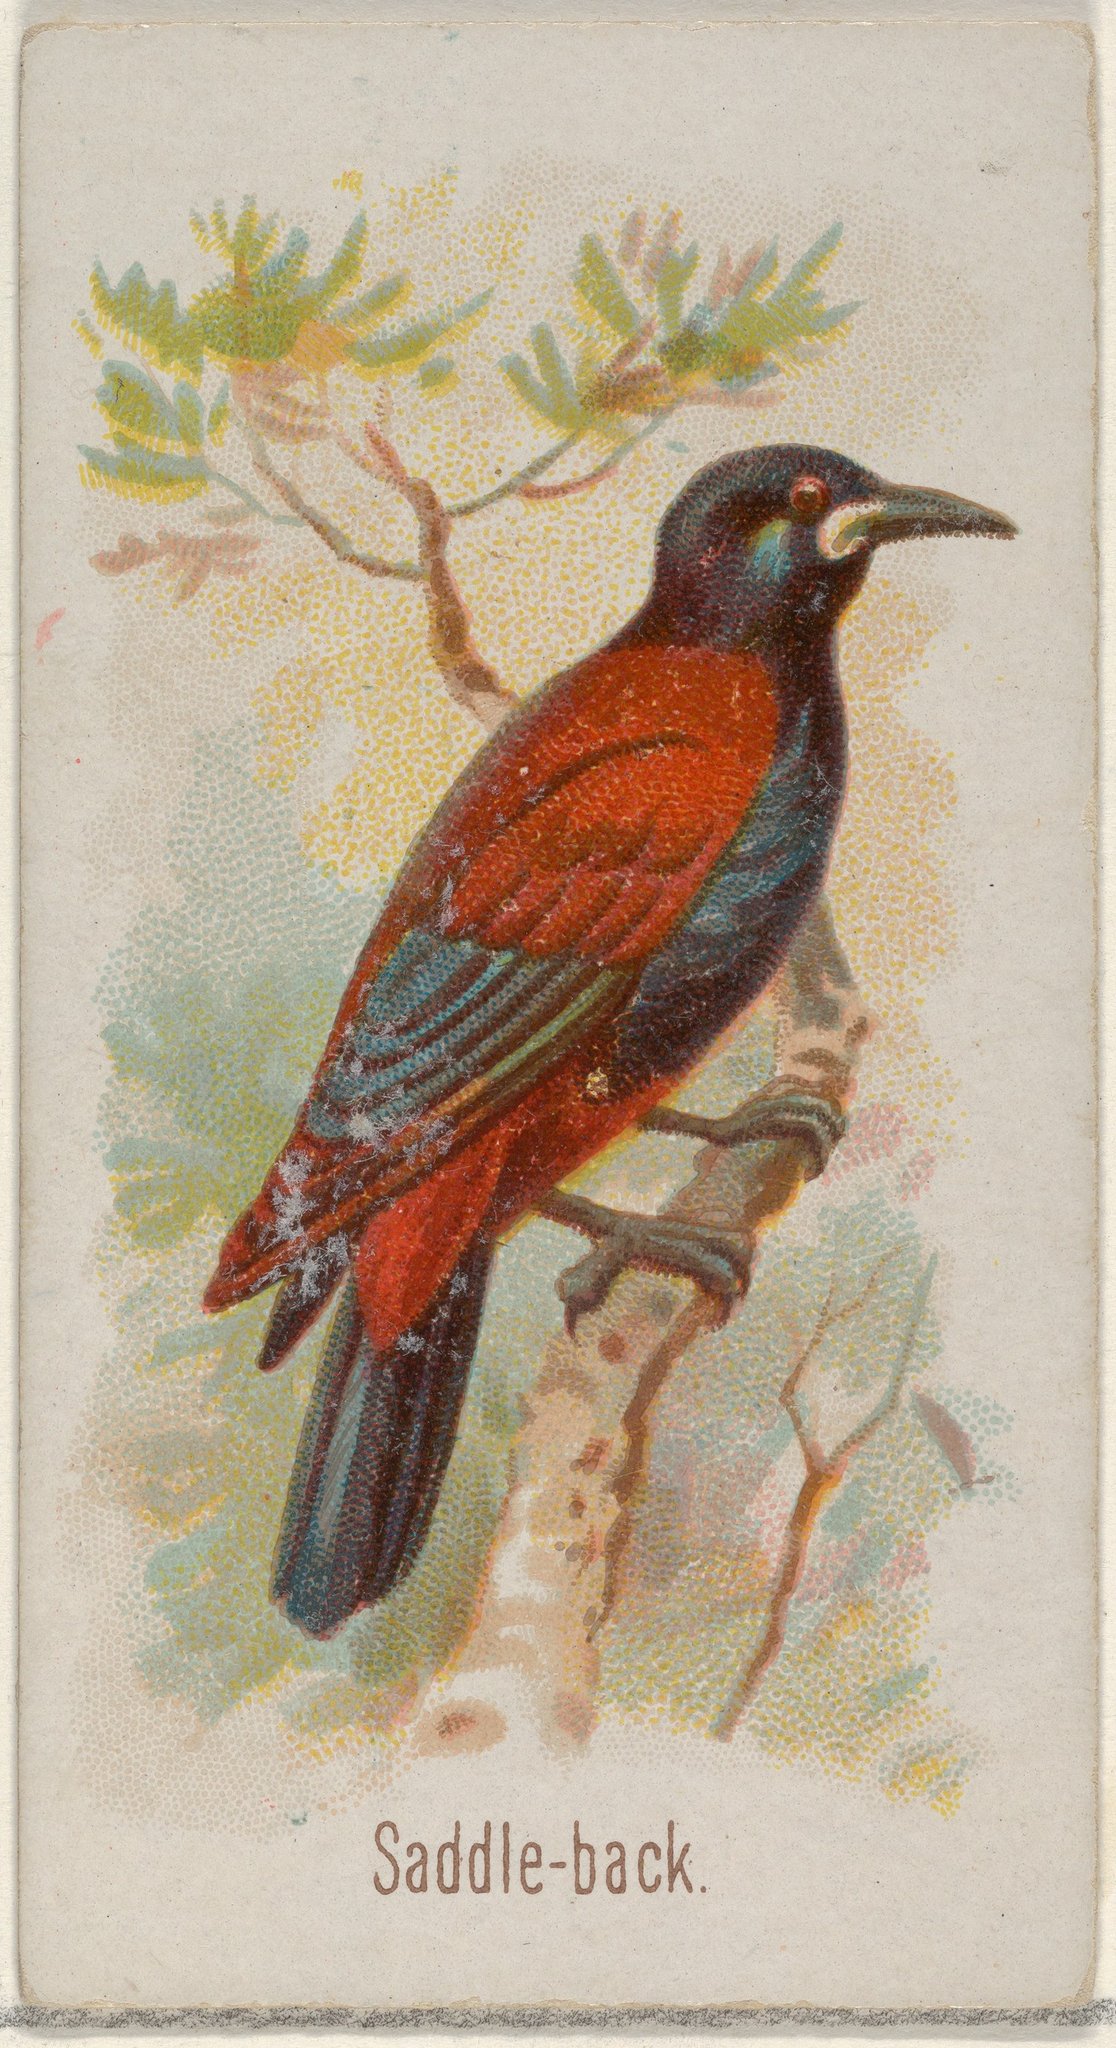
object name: print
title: Saddle-back, from the Song Birds of the World series (N23) for Allen & Ginter Cigarettes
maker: allen & ginter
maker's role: publisher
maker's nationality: american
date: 1890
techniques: color lithograph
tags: birds